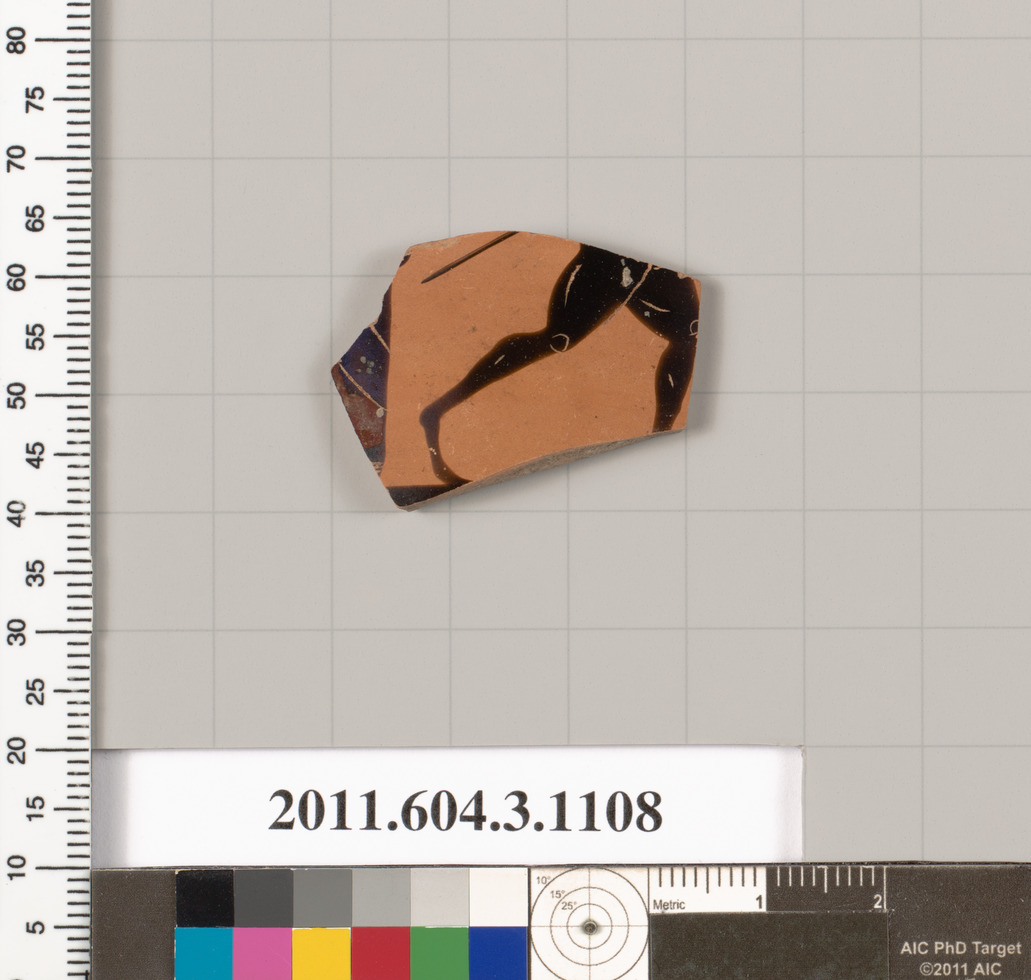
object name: mastoid or kyathos fragment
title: Terracotta fragment of a mastoid (drinking cup with narrow base) or a kyathos (cup-shaped ladle)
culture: greek, attic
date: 534-468 BCE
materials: terracotta